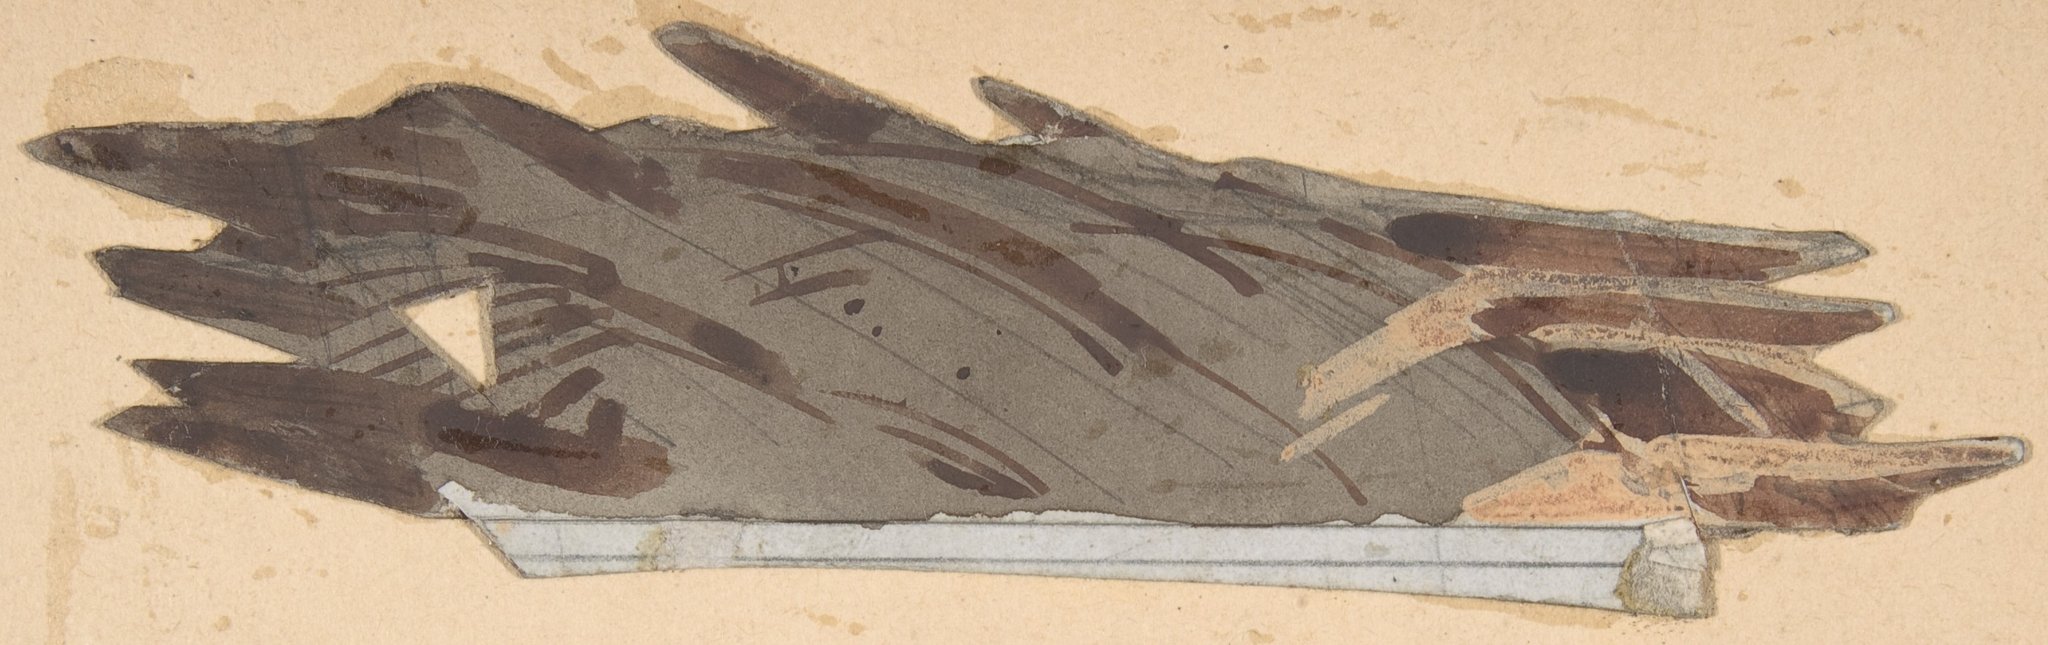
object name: drawing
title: Design for a Stage Set at the Opéra, Paris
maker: eugène cicéri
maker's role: artist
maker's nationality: french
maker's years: 1813-1890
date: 1830-1890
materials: gouache, graphite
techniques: brush, wash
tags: stage design